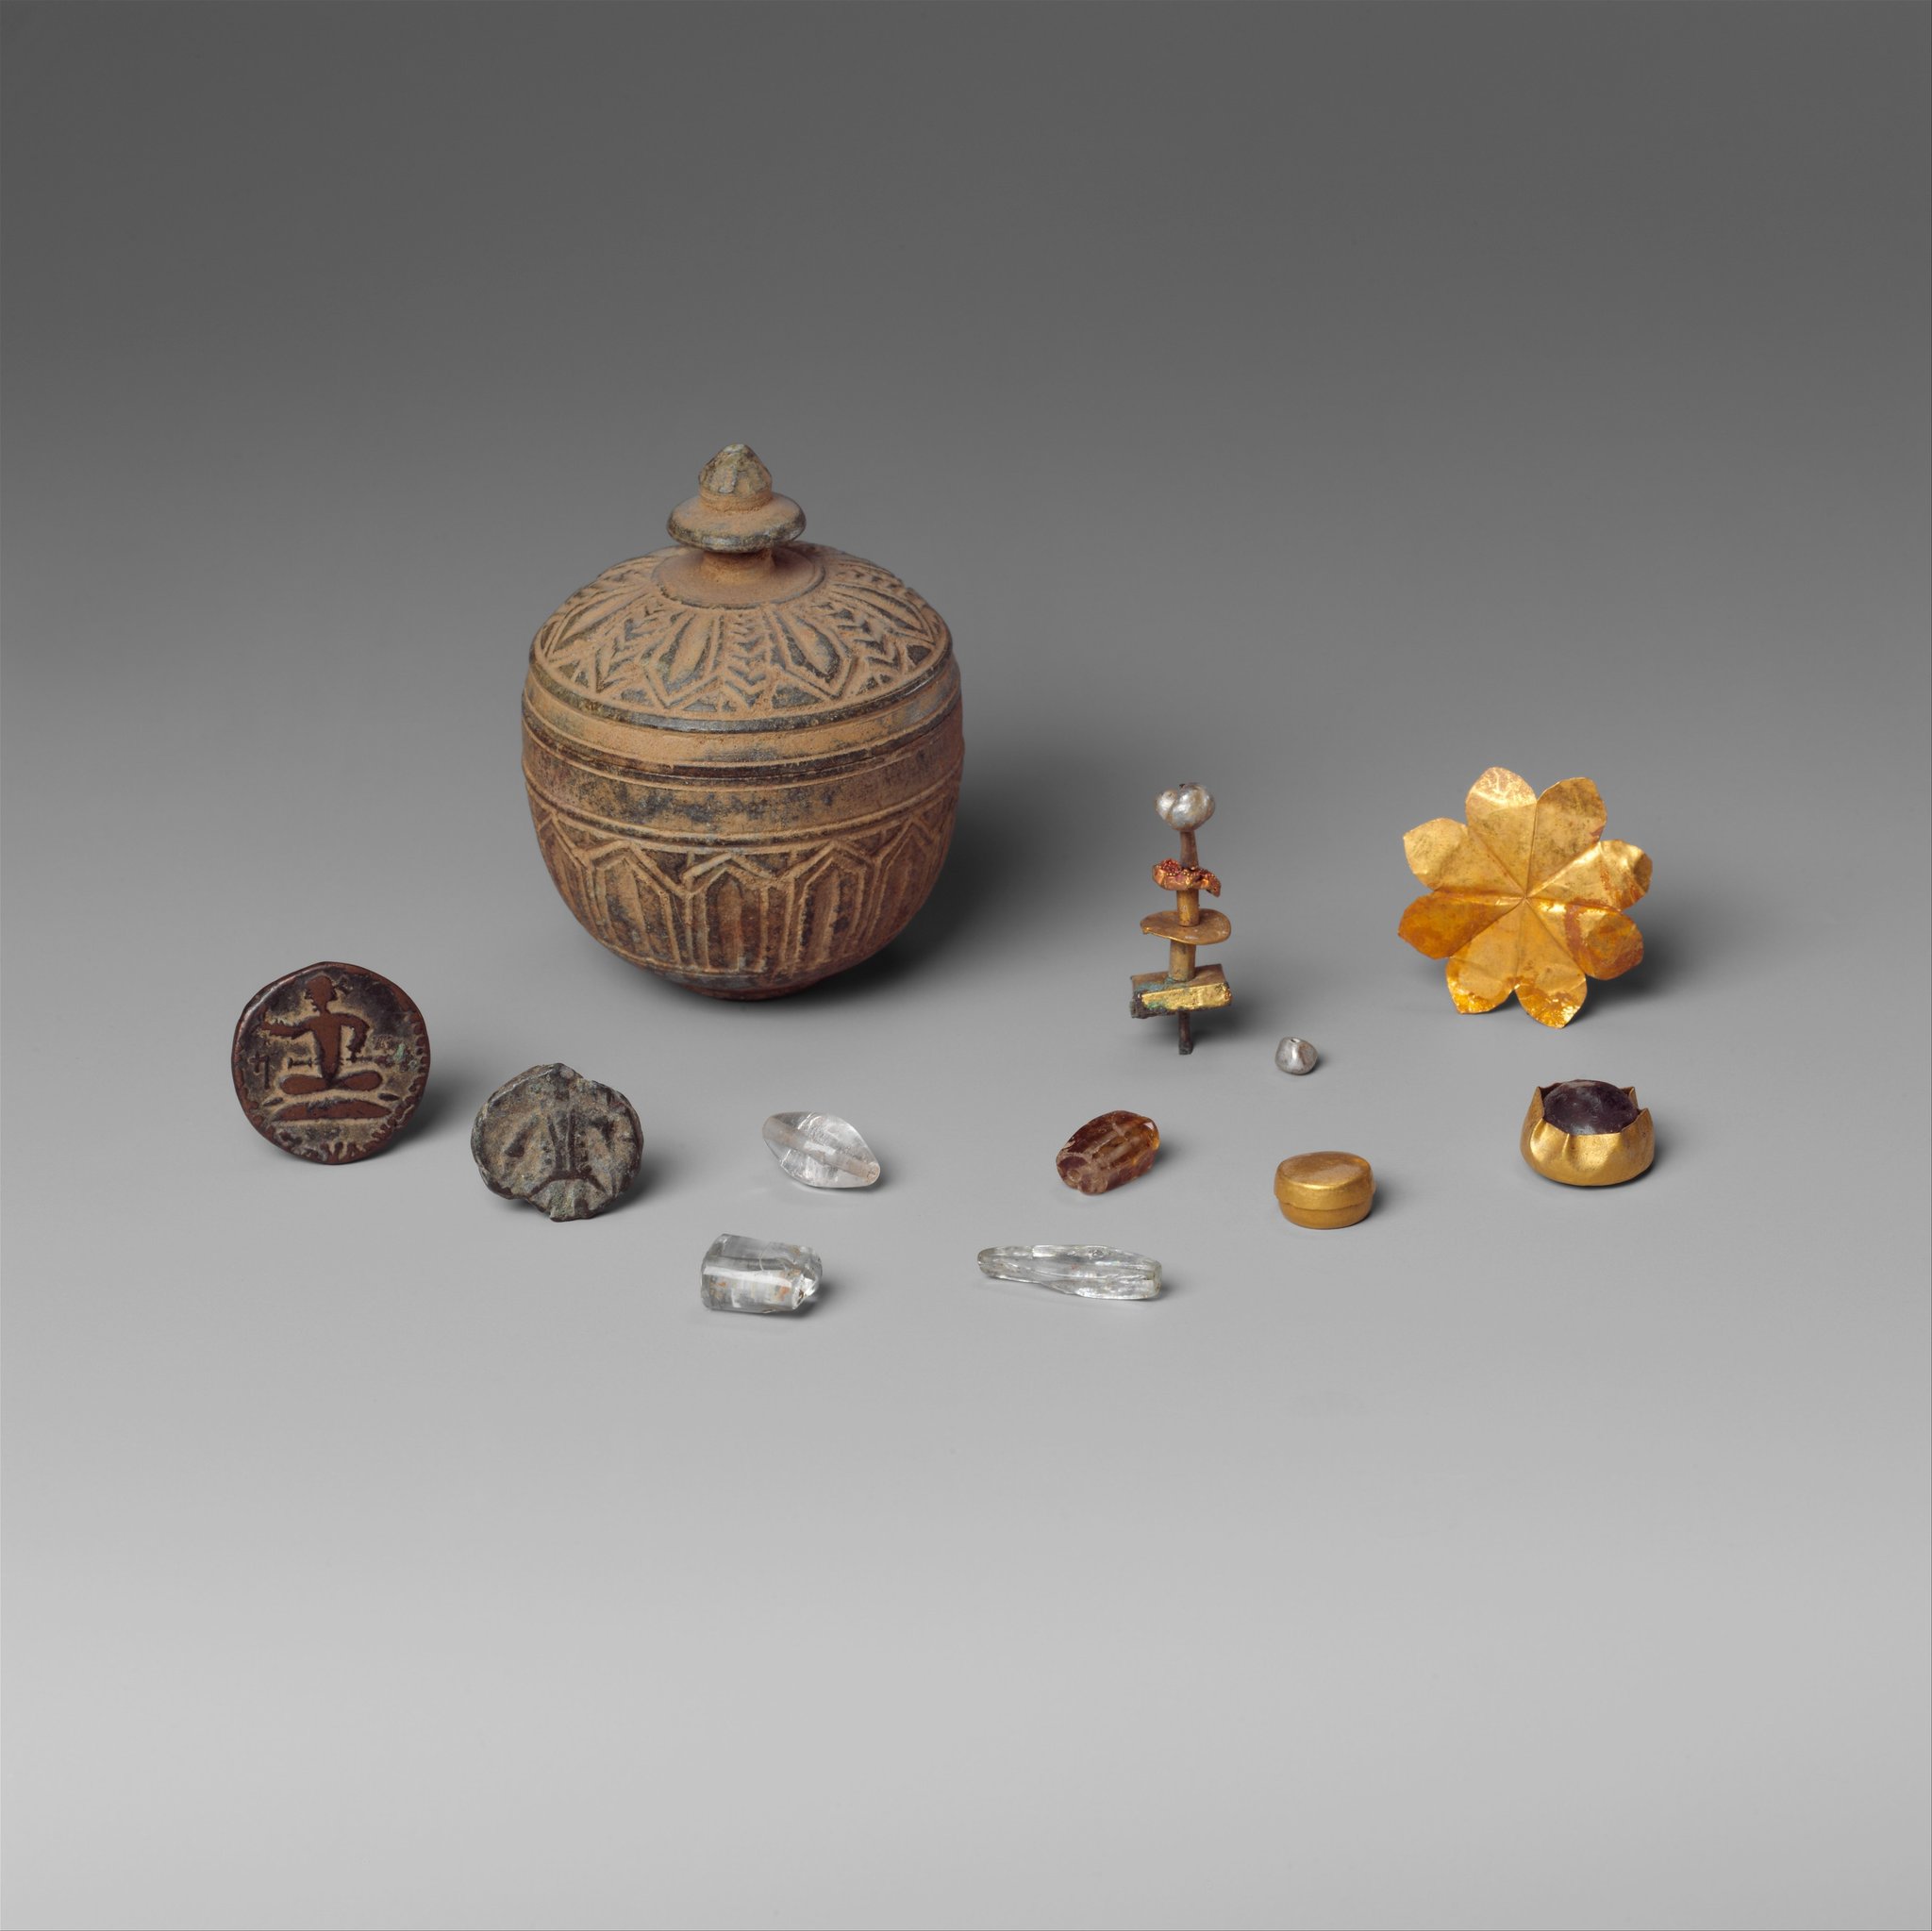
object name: reliquary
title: Reliquary with Contents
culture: gandhara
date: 1-100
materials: copper, gold, pearl, quartz, stone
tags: gandhara